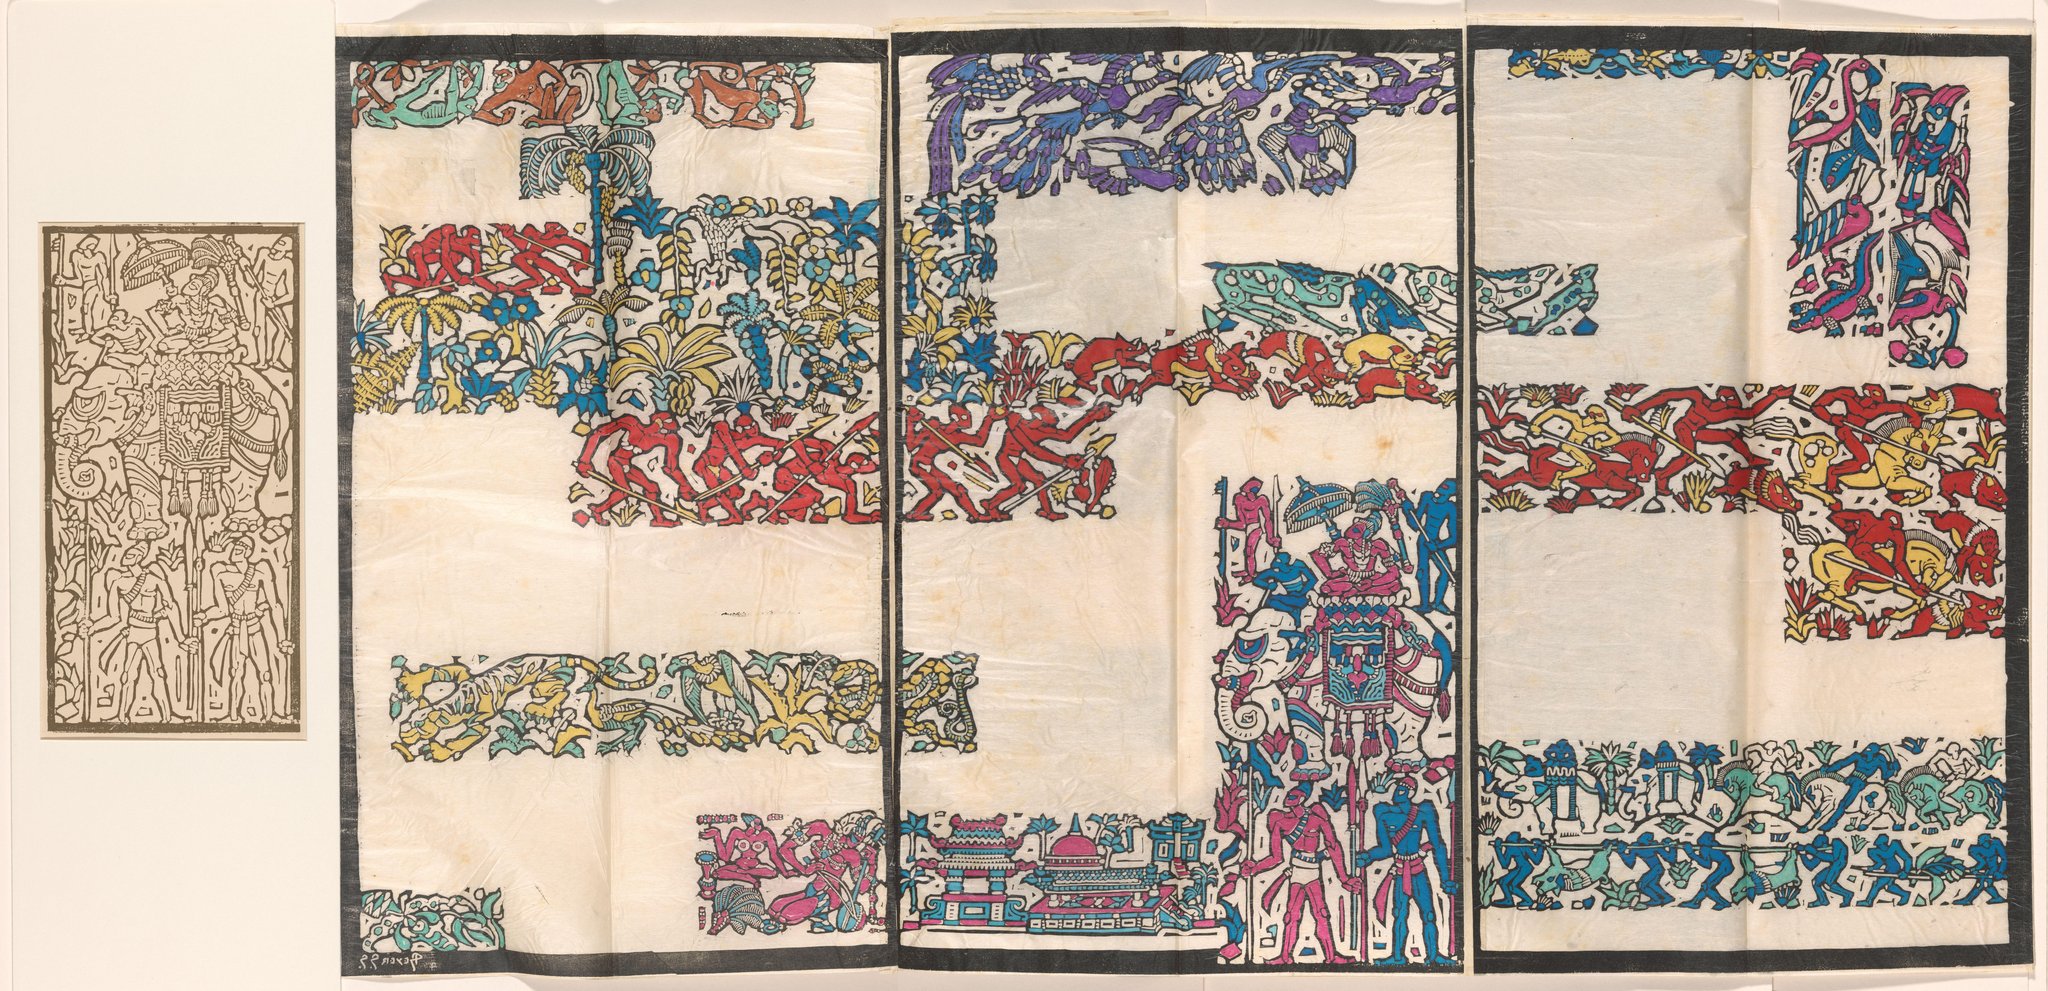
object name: print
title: Jacht op wilde zwijnen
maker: reijer stolk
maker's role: draughtsman, print maker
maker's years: 1896-1945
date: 1906-1945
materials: paper, watercolor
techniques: brush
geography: netherlands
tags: boar-hunting, trunked animals: elephant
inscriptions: collector's mark: Lugt 2228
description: Op het voorste blad een voorstelling in goud van een olifant met op zijn rug een figuur onder een parasol. Onderaan twee soldaten. Erachter op gevouwen blad een voorstelling van een groep jagers die op wilde zwijnen jagen. Eromheen horizontale en verticale friezen met apen, vogels en menselijke figuren. Rechtsonder nogmaals de voorstelling met de olifant in paars en blauw.